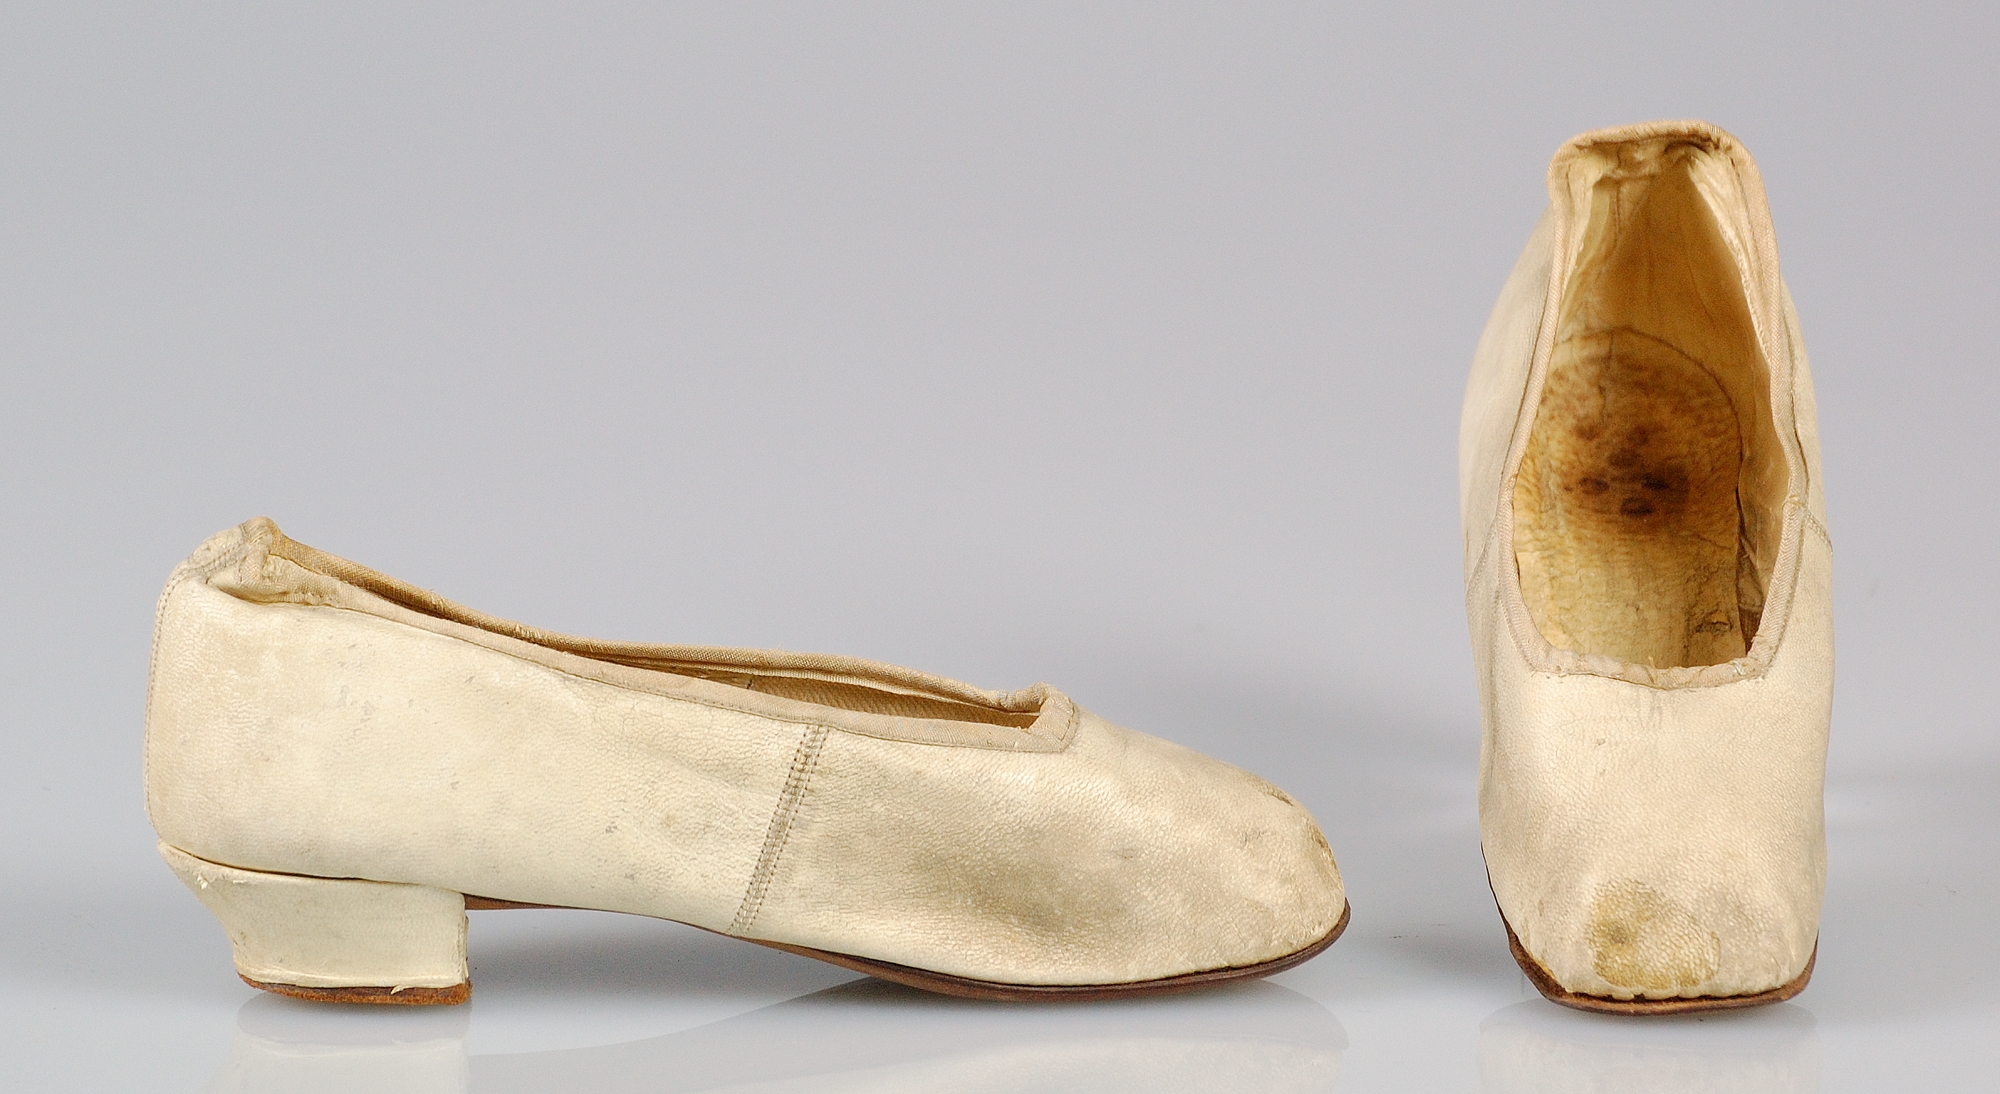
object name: slipper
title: Slippers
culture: american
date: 1873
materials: leather